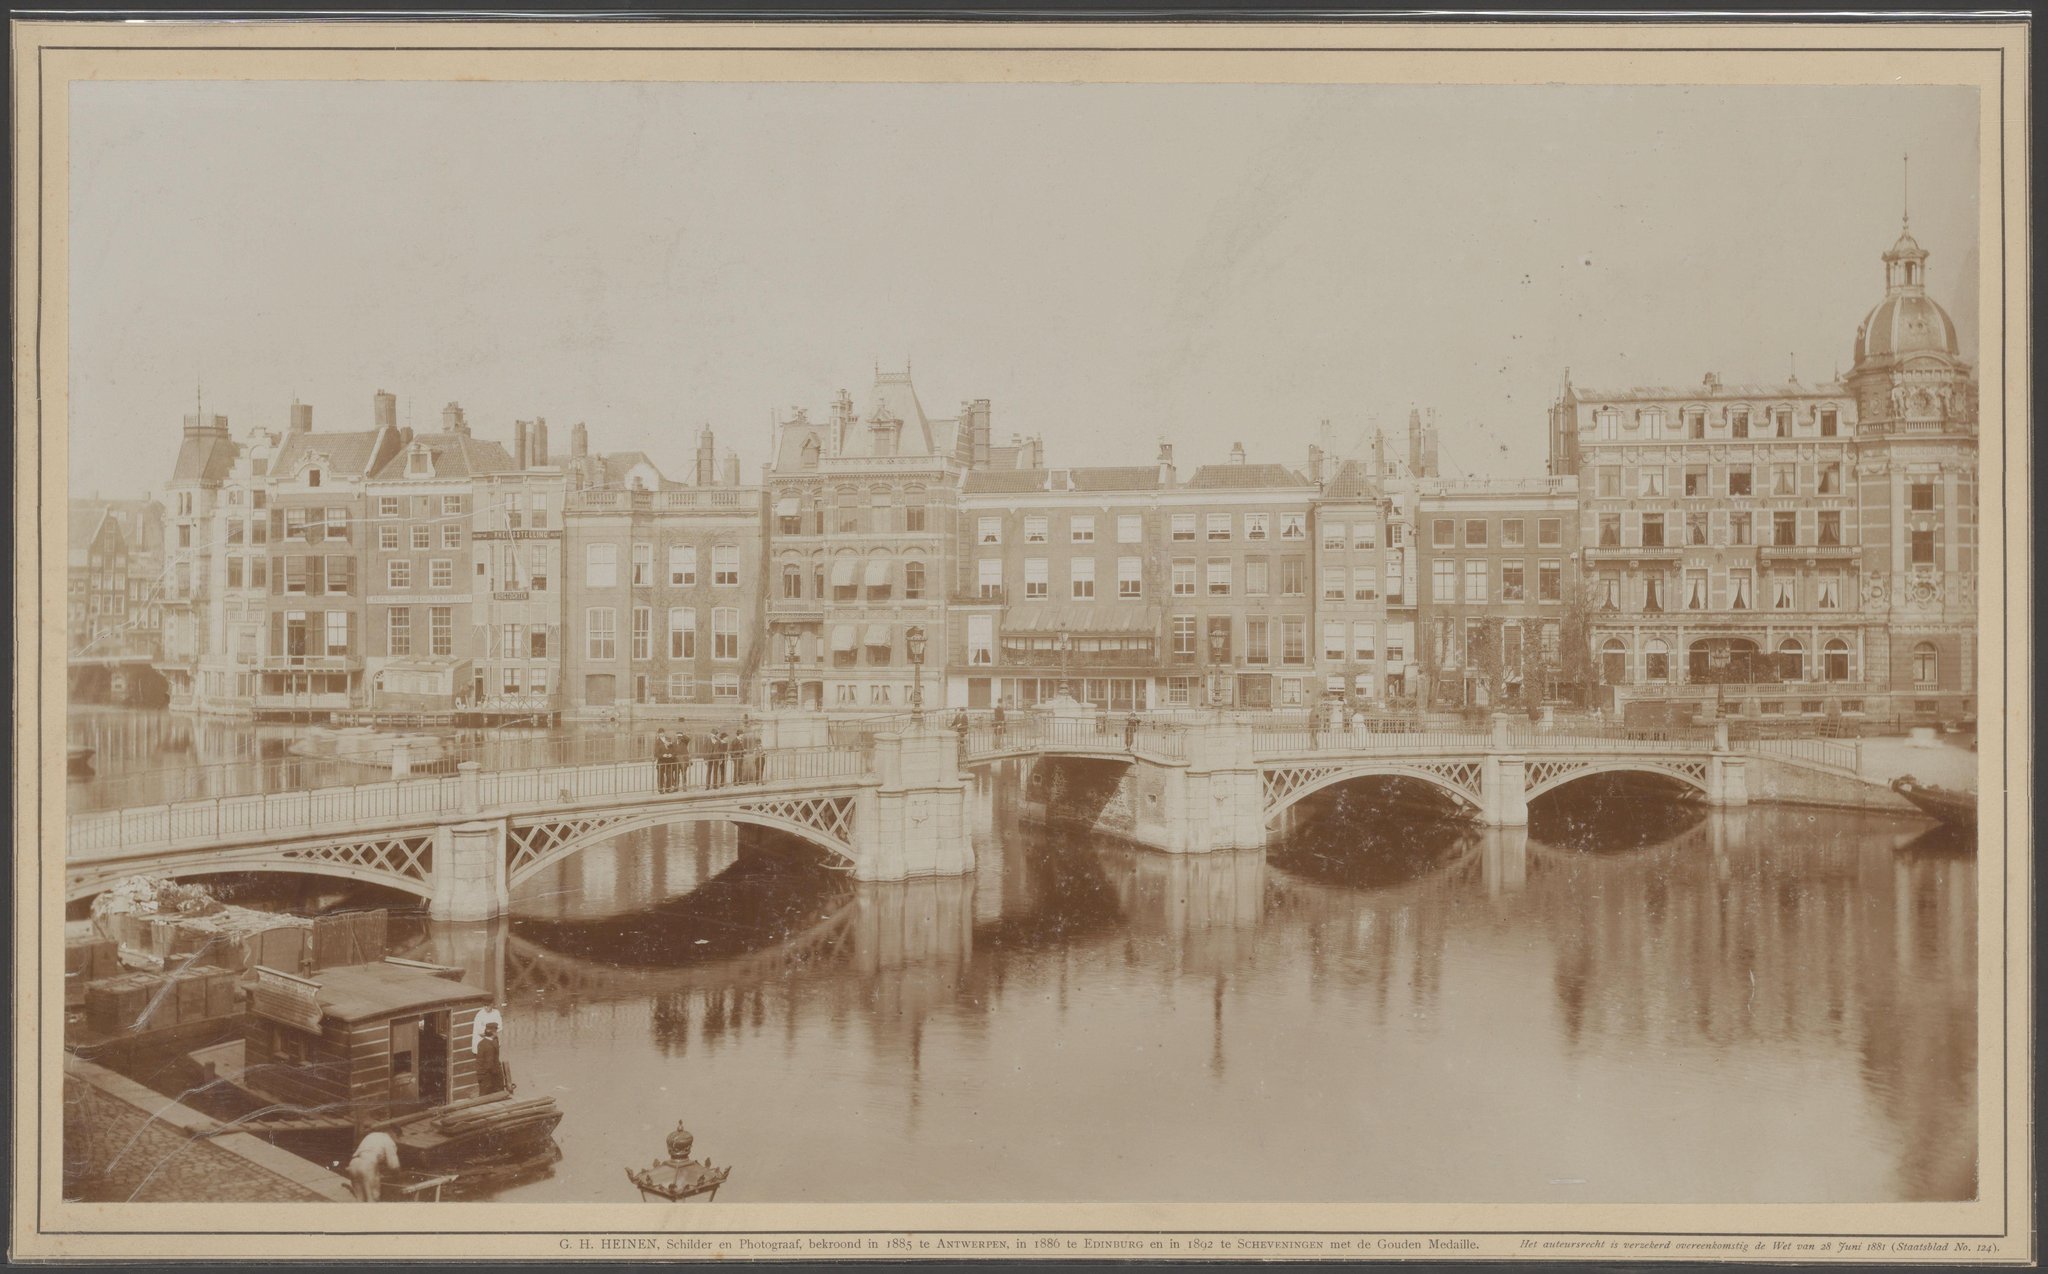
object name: photograph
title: Gezicht op de Halvemaansbrug en het Doelenhotel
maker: gerrit hendricus heinen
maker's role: painter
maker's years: 1851-1930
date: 1892-1930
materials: paper, cardboard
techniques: gelatin silver print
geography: amsterdam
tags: city-view in general; 'veduta', canal, bridge in city across river, canal, etc., hotel, hostelry, inn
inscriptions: inscription: ‘op een der perceelen / S Ru[...]co glasfabrikanten / eng[...] export / Legaat Joh. M. Coffeng 1966.’, collector's mark: ‘4A’ Lugt 1641b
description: Onderwerpsrubriek binnen de Atlas Amsterdam: Amstel van Doelensluis tot Blauwbrug.